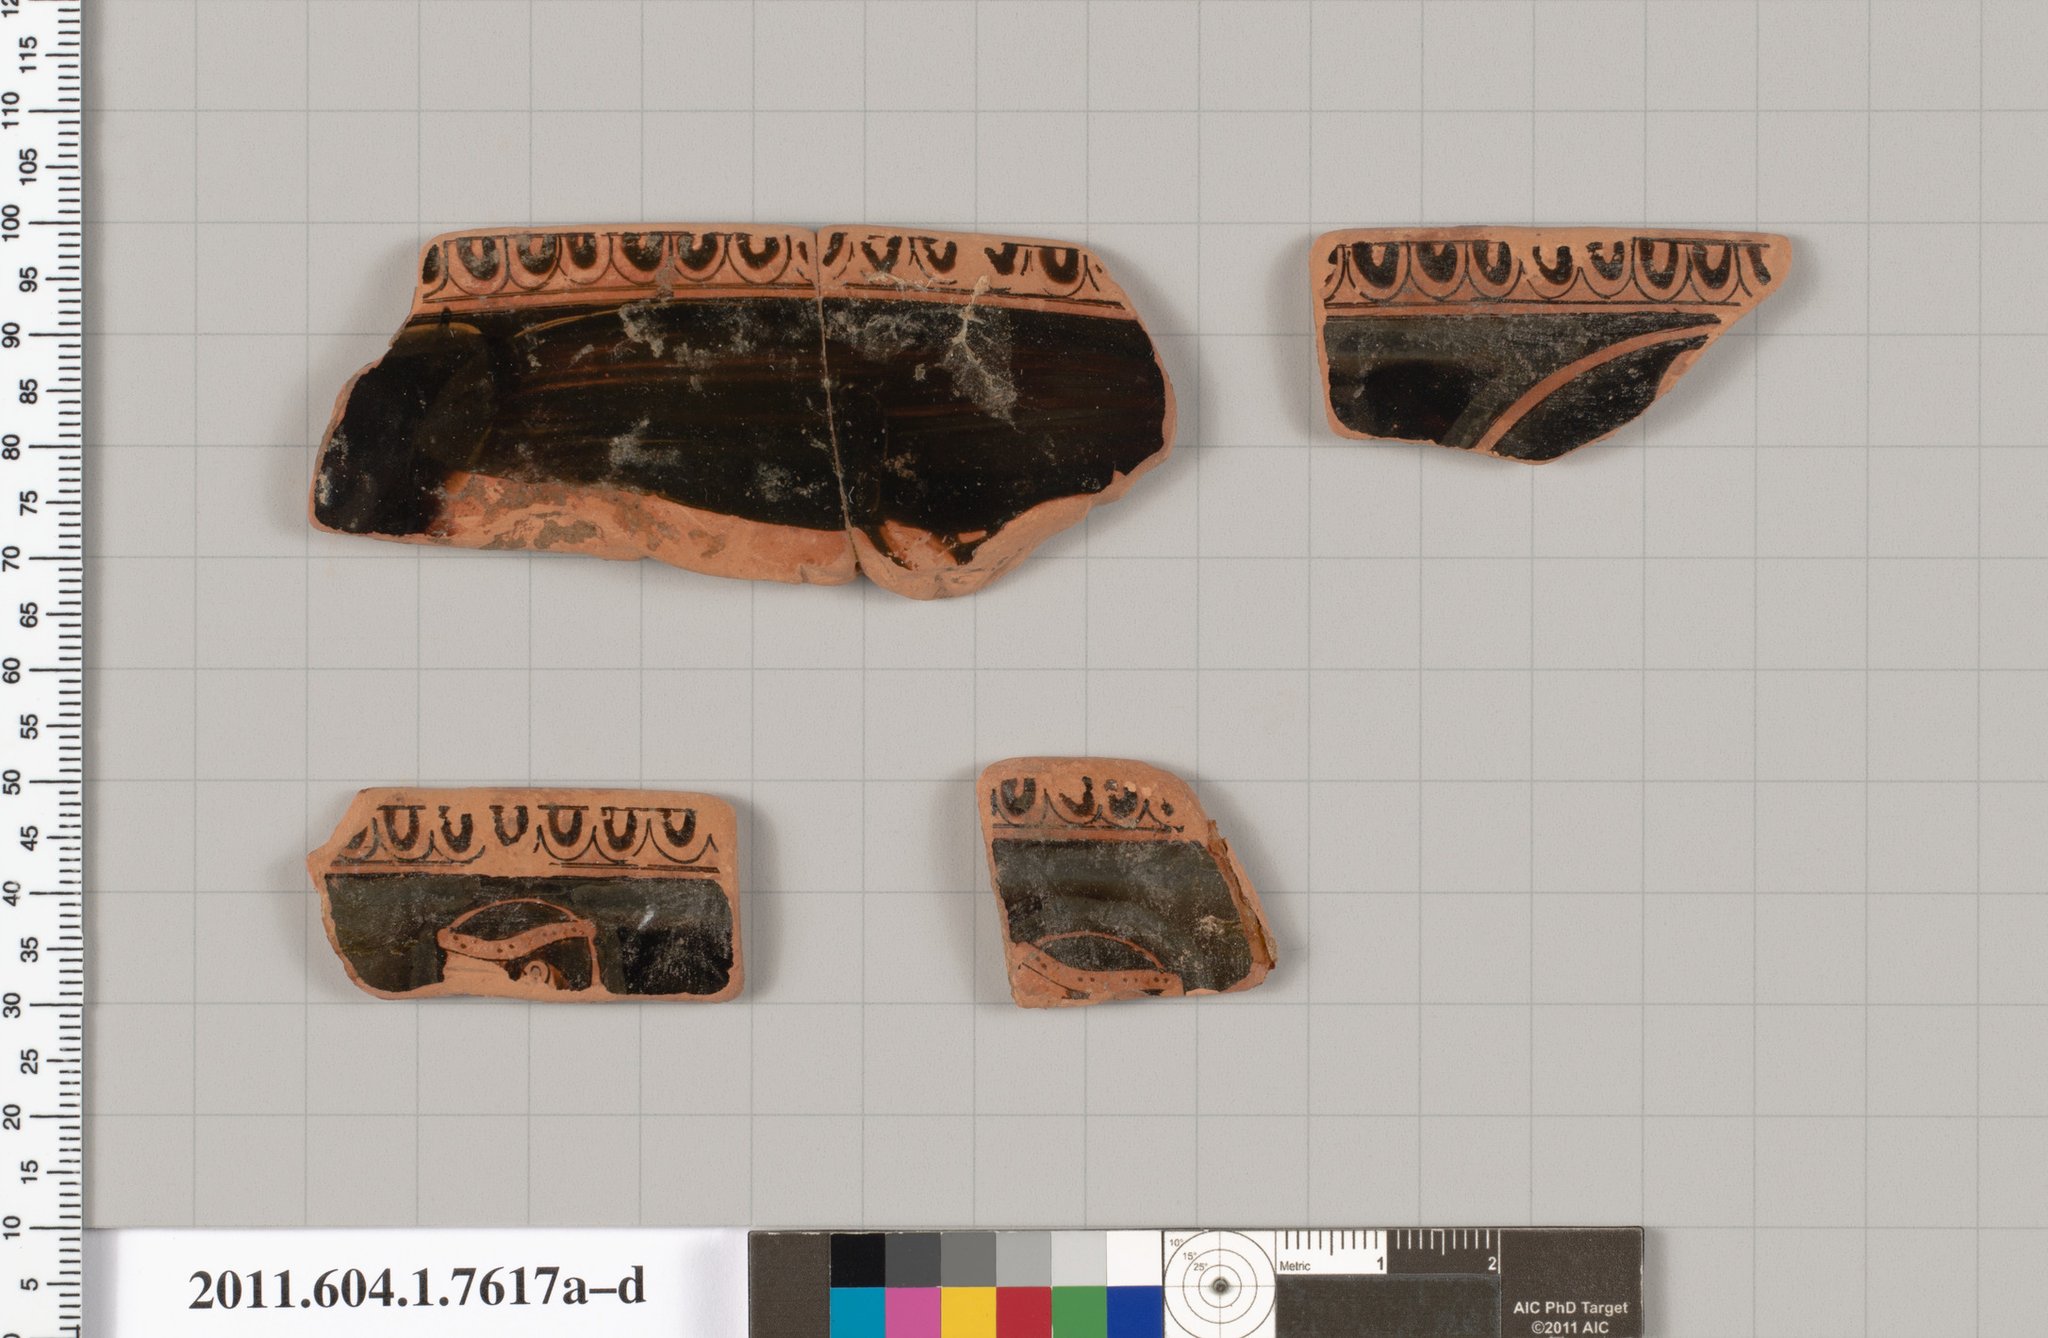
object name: kylix fragment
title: Terracotta rim fragments of a kylix (drinking cup)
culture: greek, attic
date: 460-450 BCE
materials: terracotta